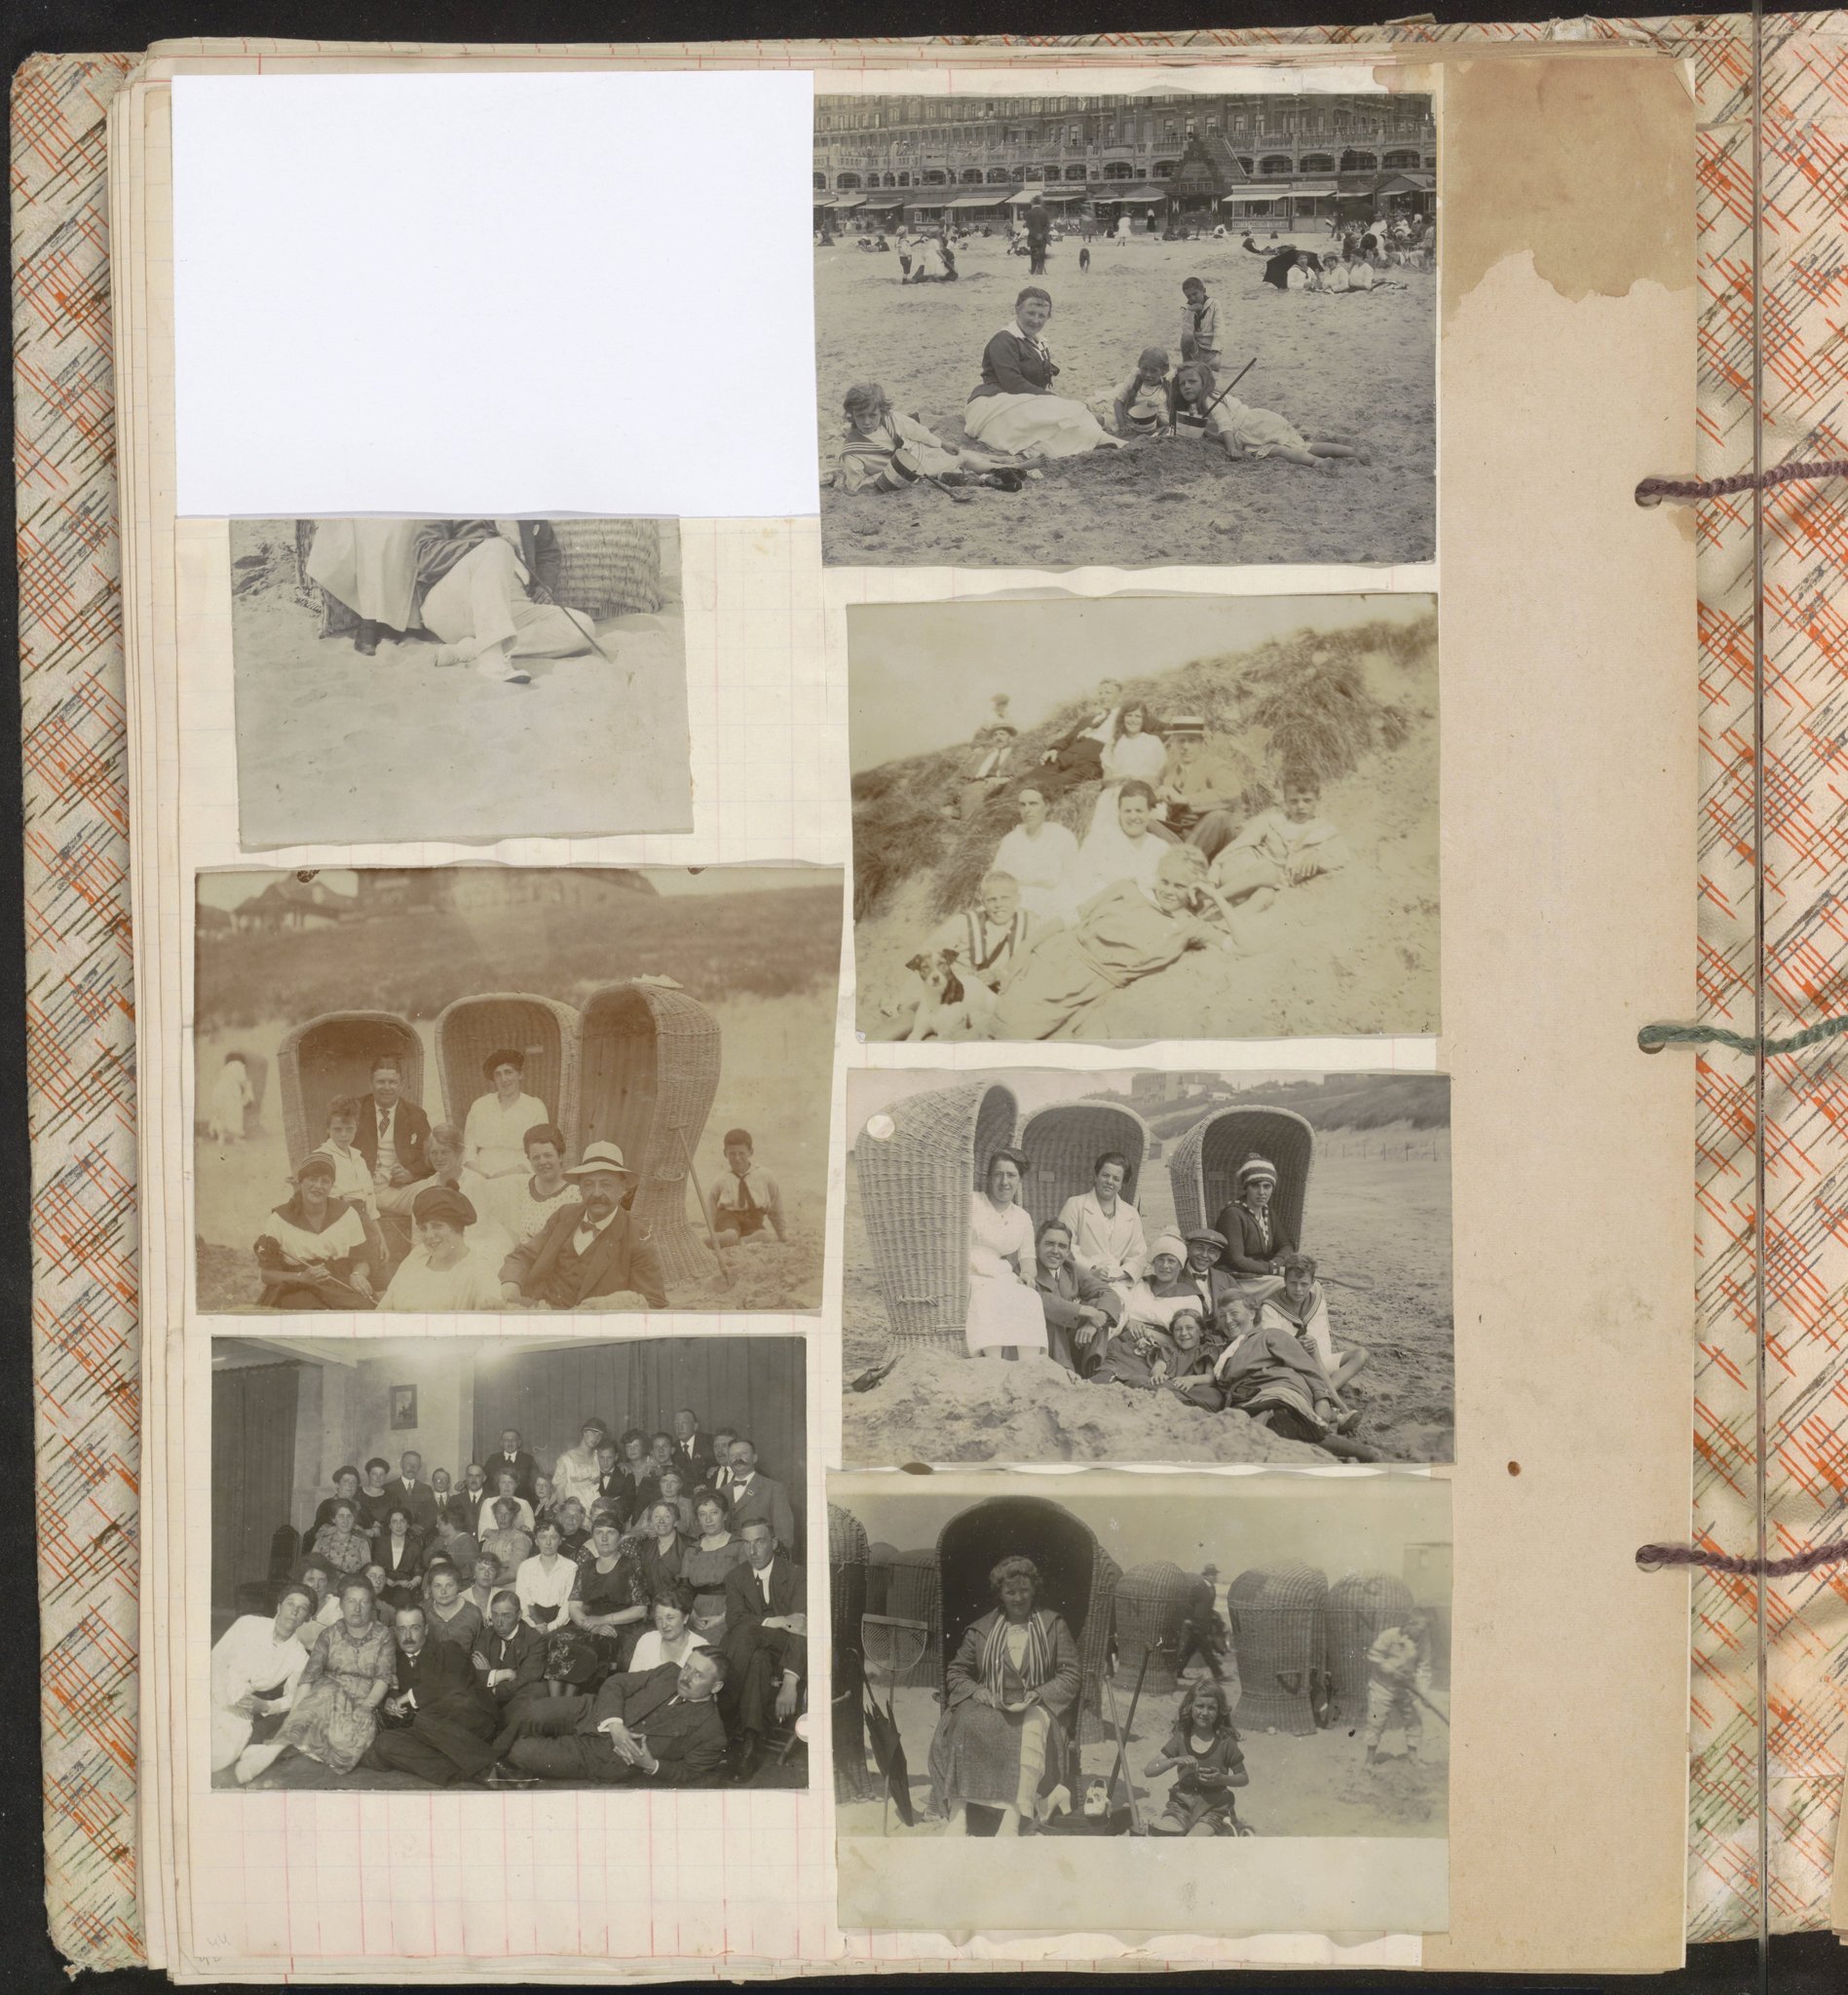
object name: photograph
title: Portretten van onbekende personen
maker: Anonymous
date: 1910-1930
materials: paper, photographic support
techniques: gelatin silver print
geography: netherlands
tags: beach (as place of recreation), adult woman, adult man, child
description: Albumblad met groepsportretten van volwassenen en kinderen aan het strand. Ook een groepsfoto's van een gezelschap in een zaal. Onderdeel van Fotoalbum van de familie Petri.